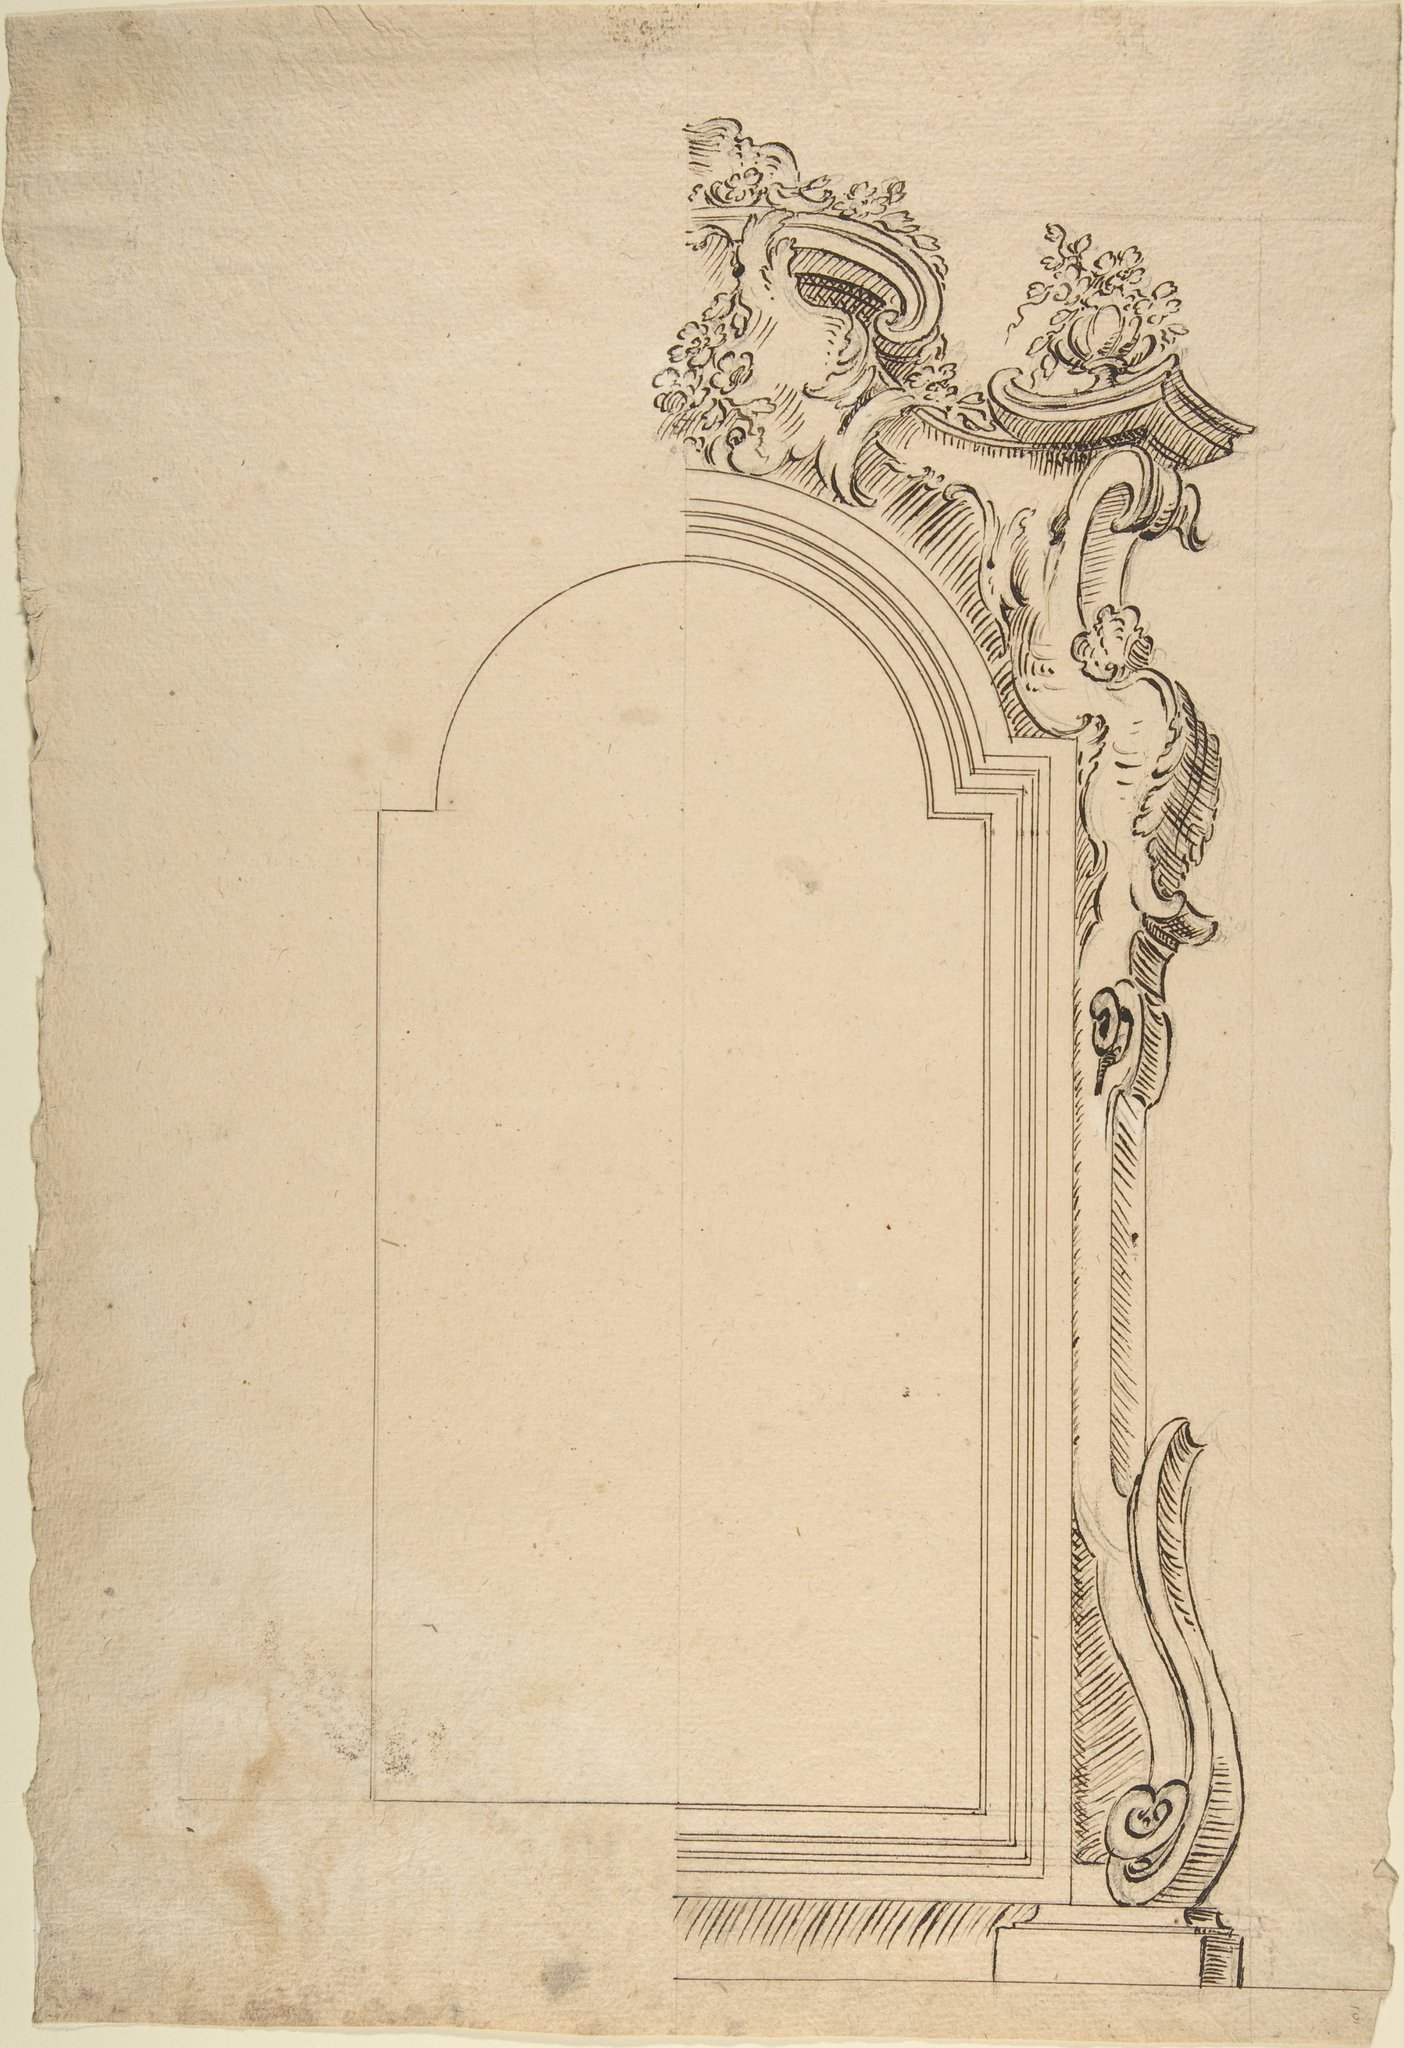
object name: drawing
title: Design for one Half of a Frame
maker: anonymous, italian, piedmontese, 18th century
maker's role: artist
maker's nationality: italian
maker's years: 1700-1800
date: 1700-1780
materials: graphite, ink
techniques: pen